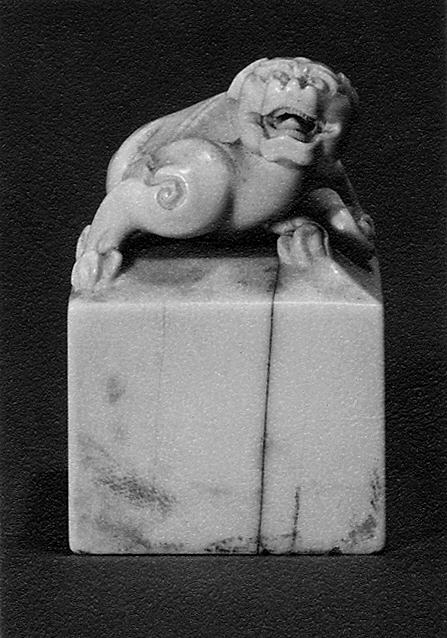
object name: seal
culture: chinese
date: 1701-1800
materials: ivory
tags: animals